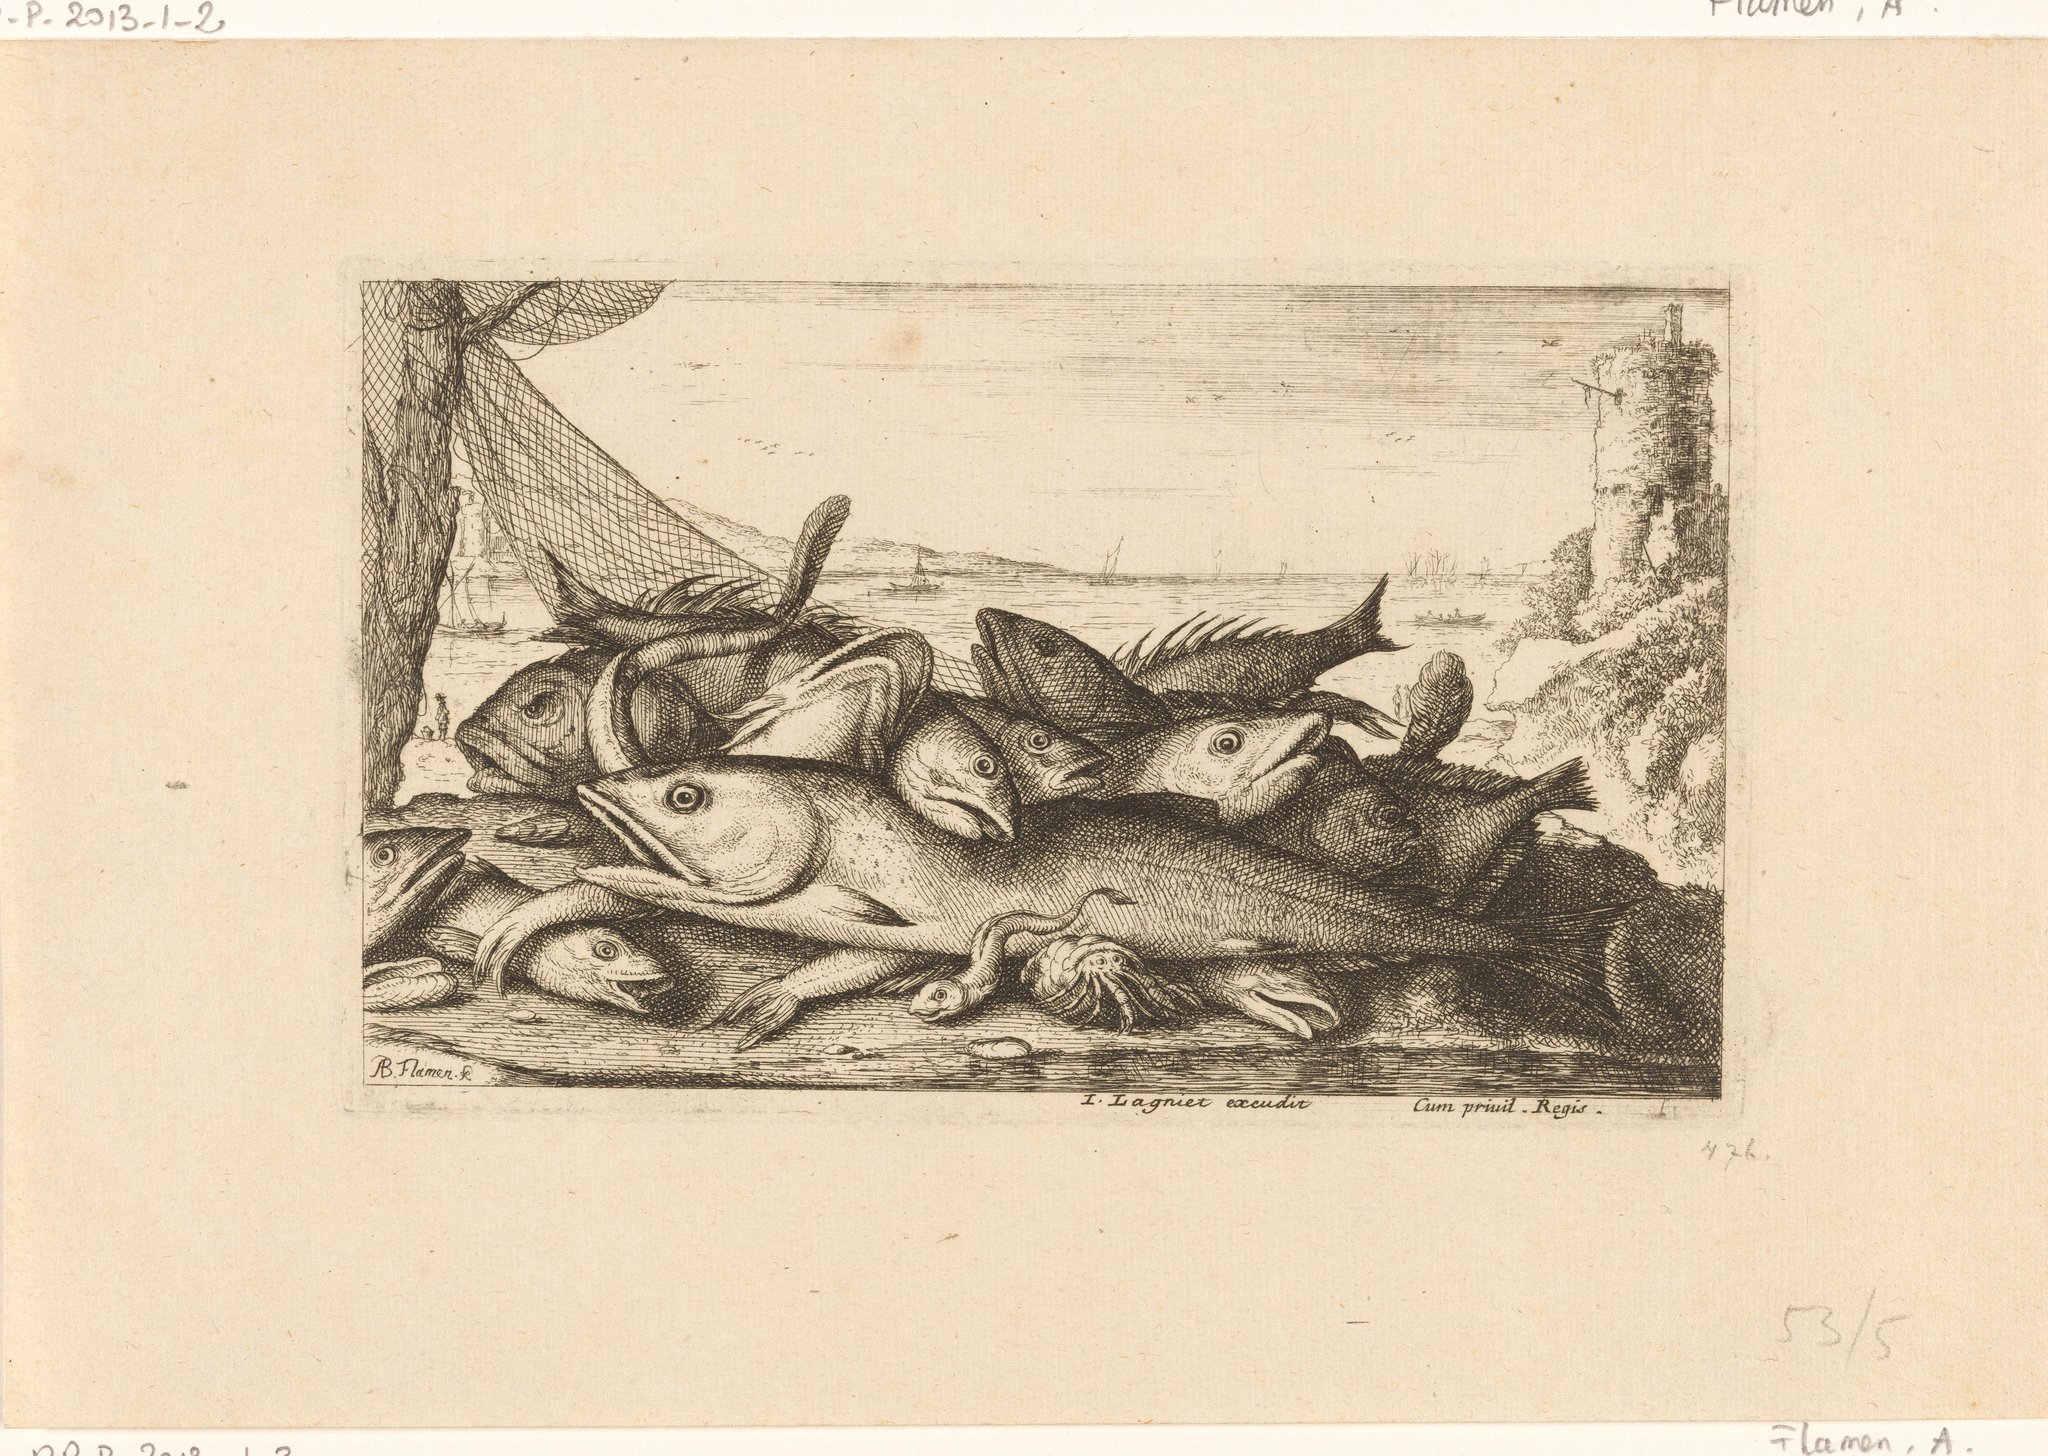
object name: print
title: Visvangst met heremietkreeft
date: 1648-1670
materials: paper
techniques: etching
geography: paris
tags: fishes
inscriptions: number: ‘53/5’, collector's mark: Lugt 2749, number: ‘6854/5’, number: ‘476.’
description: Verschillende vissen op een hoop, bij een visnet. Op de achtergrond een toren op de oever van een brede rivier.